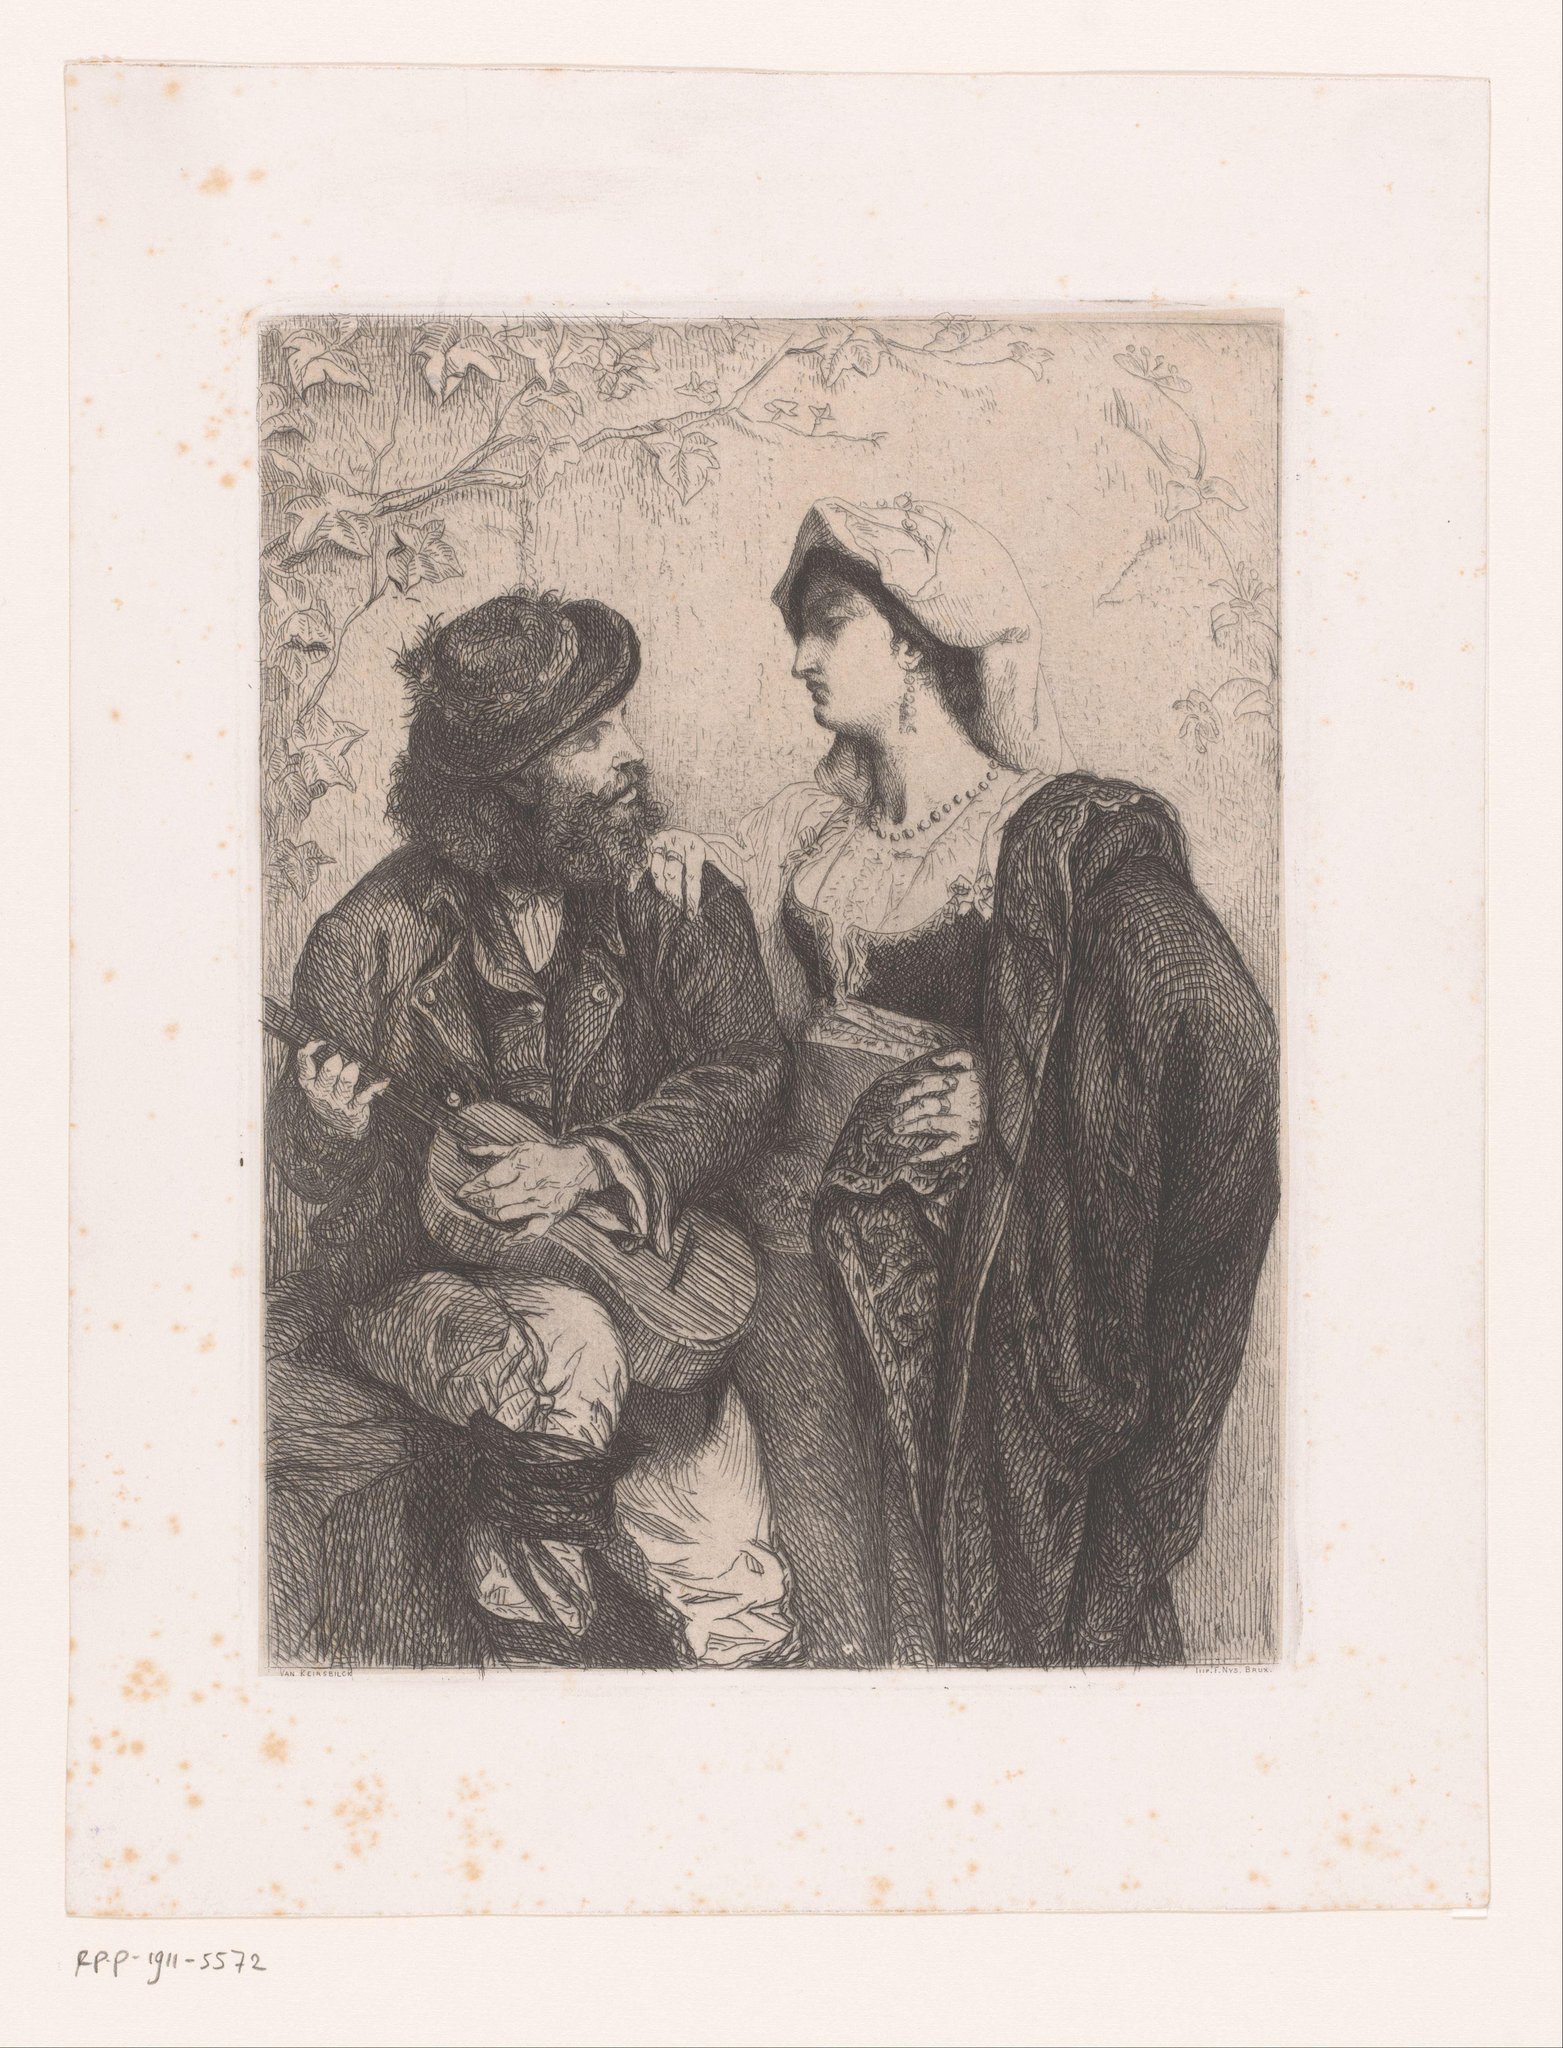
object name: print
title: Vrouw steunt met haar arm op de schouder van een man met gitaar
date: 1874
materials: paper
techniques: etching, intaglio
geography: brussels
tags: adult woman, musician - cc - out of doors, cithern, mandolin, guitar, balalaika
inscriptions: collector's mark: Lugt 2228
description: Prent verschenen in: Album du journal des Beaux-Arts, dix eaux-fortes inédites. Brussel: Decq et al., 1874.